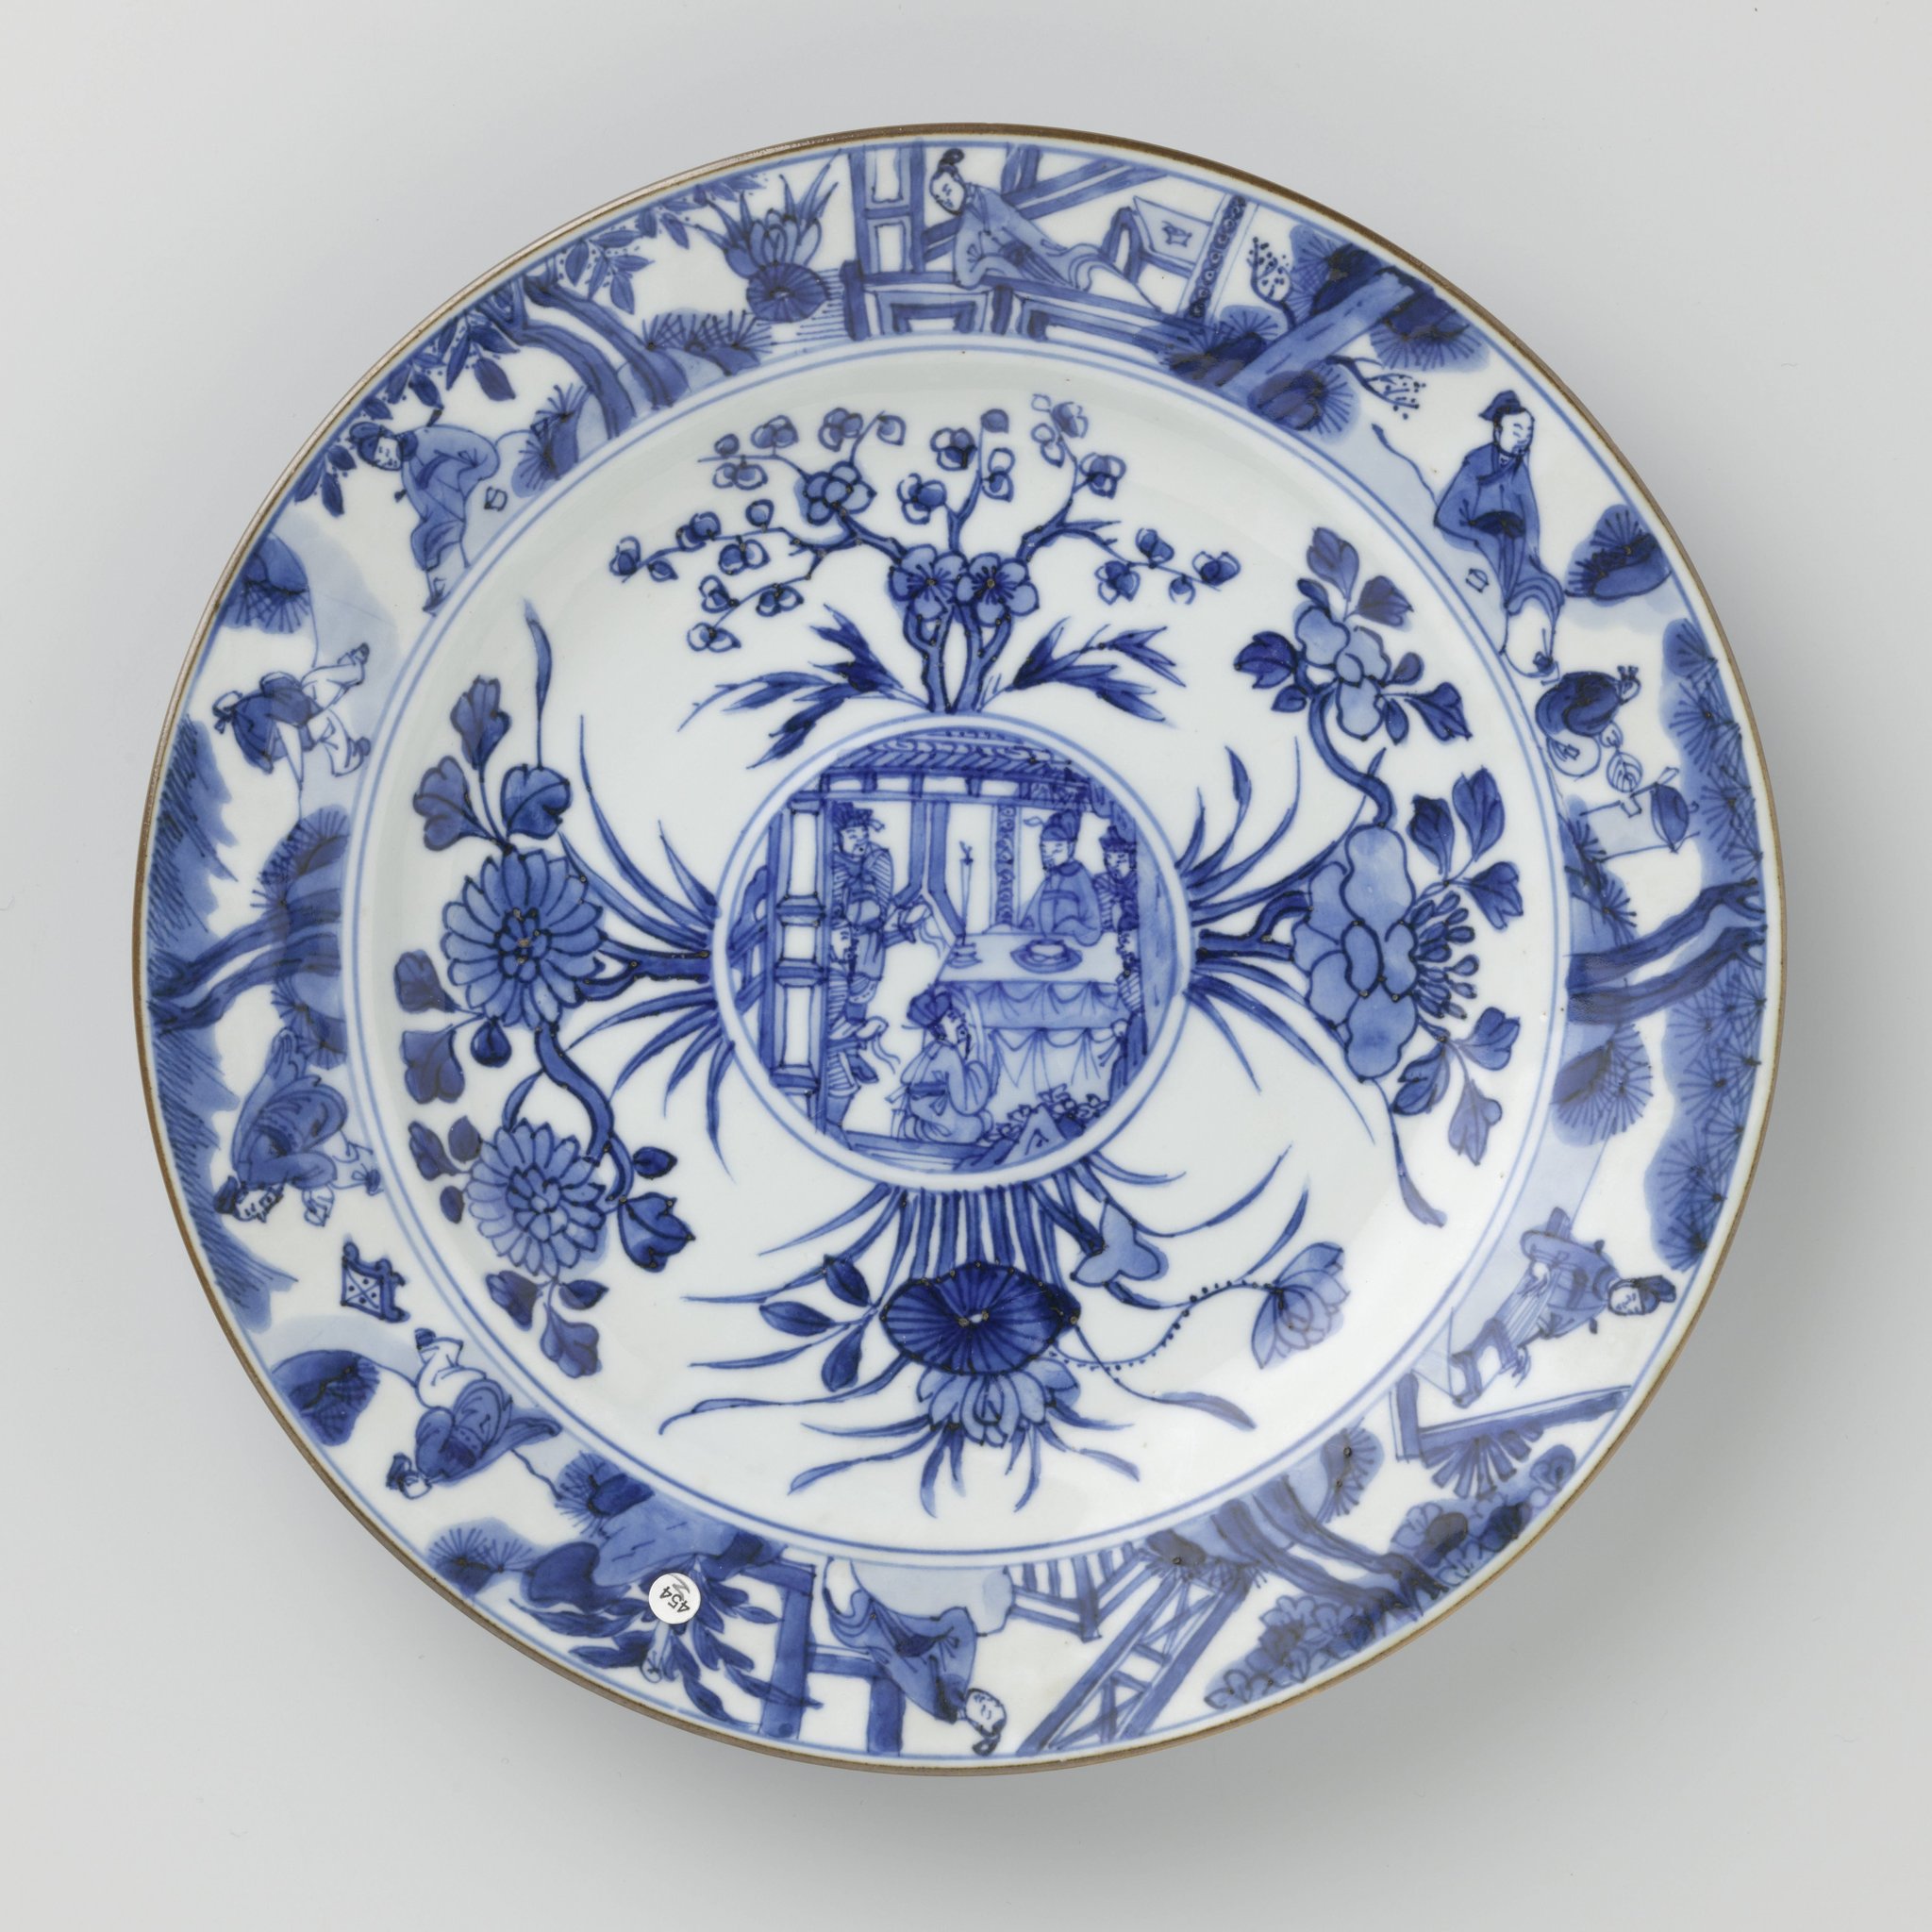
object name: plate dish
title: Plate with flower sprays and figures in an interior and in a landscape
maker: Anonymous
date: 1700-1724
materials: cobalt, glaze, paint, porcelain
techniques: firing, turning, vitrification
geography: china